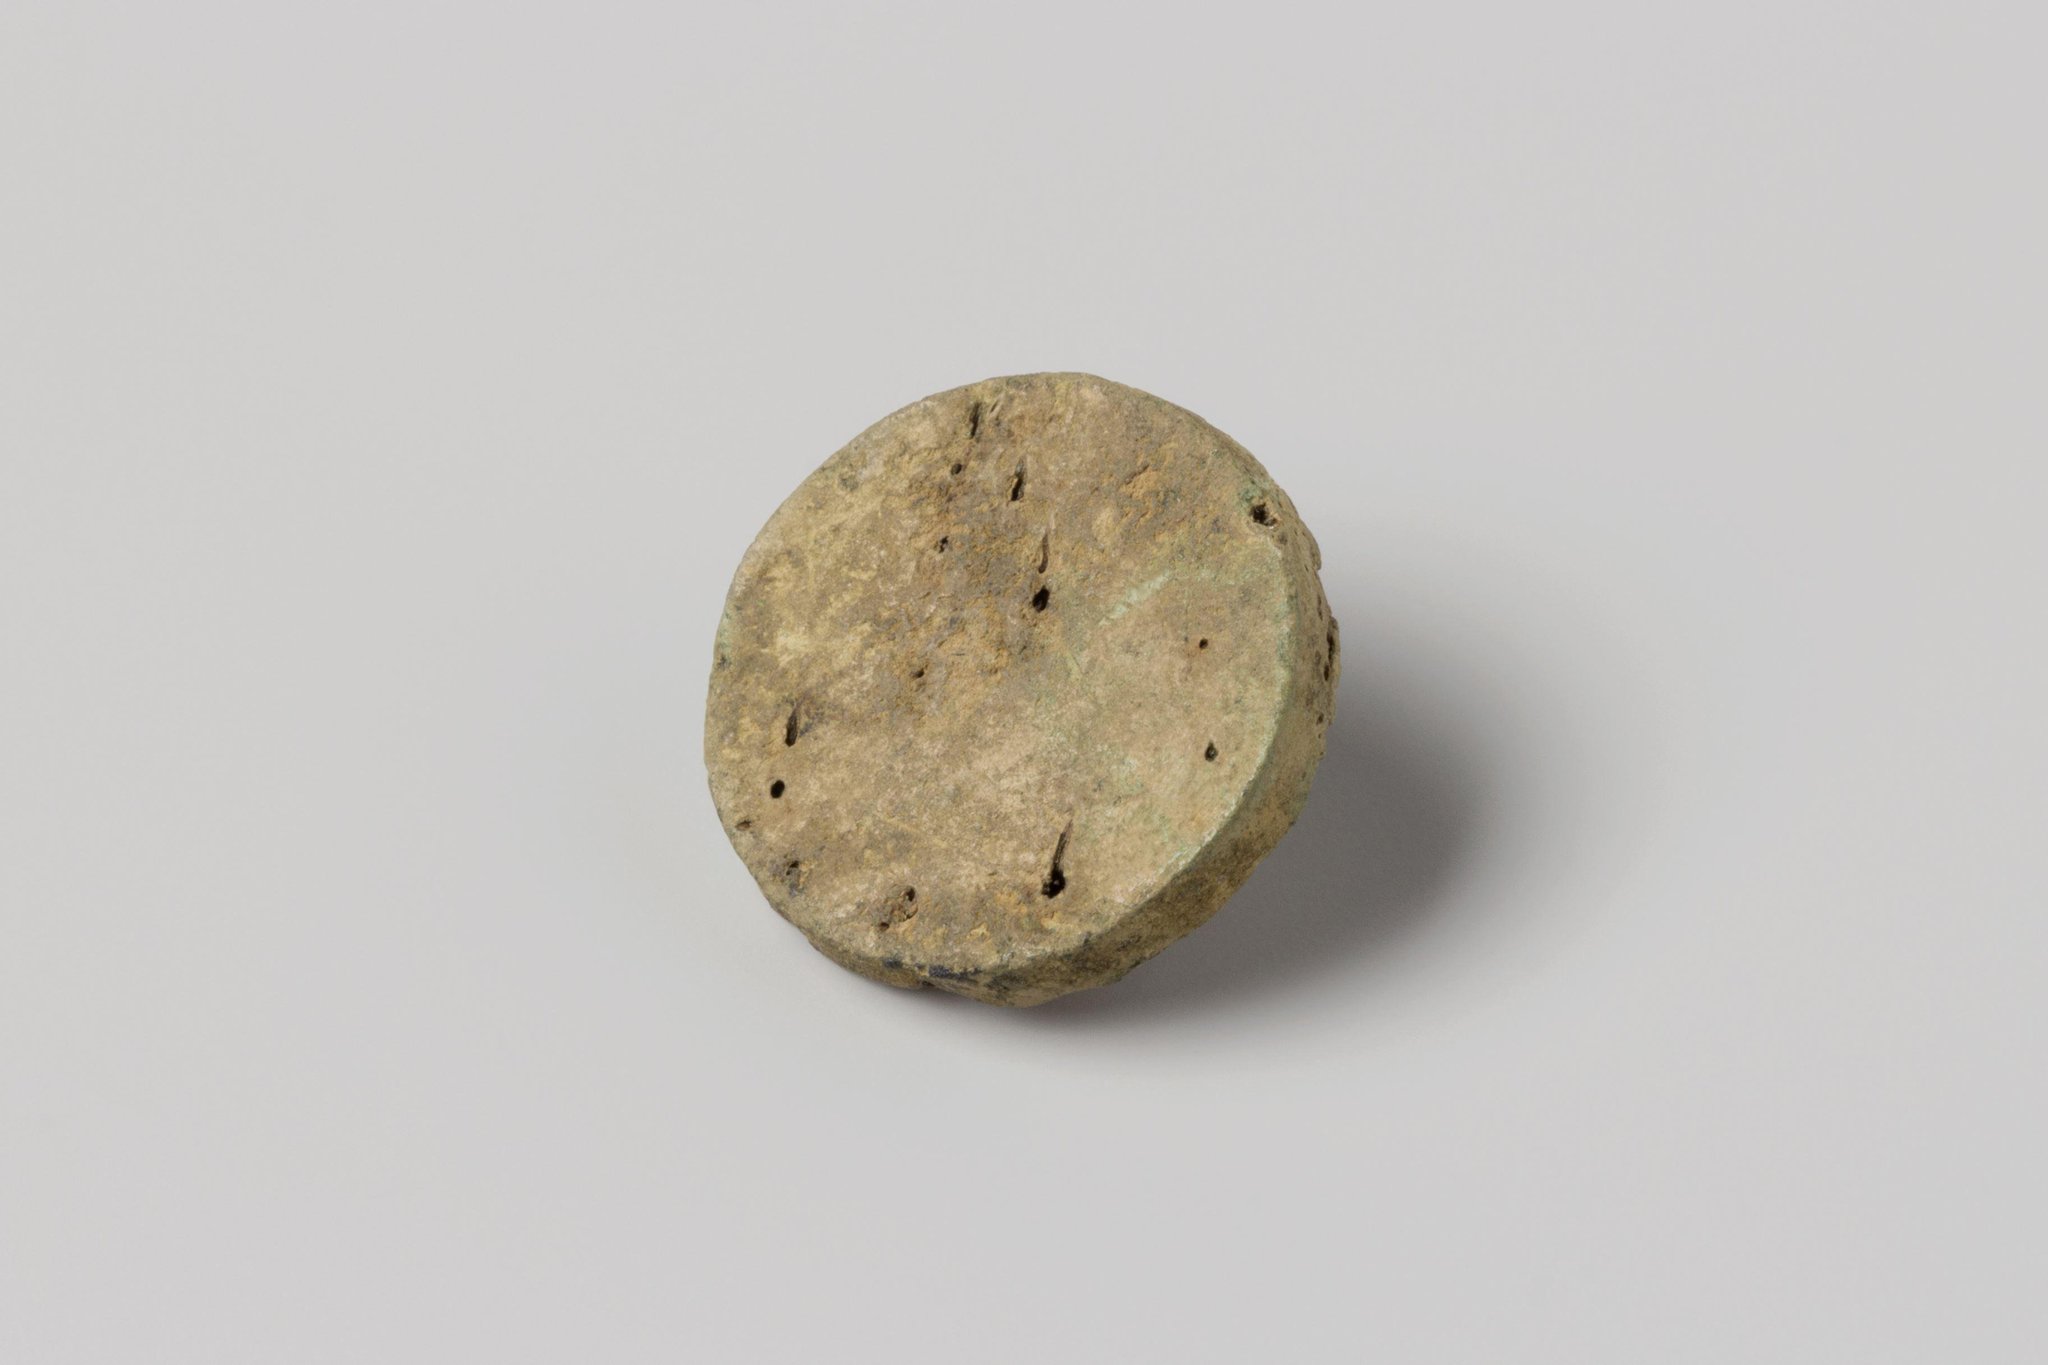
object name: button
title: Knoop uit het wrak van de Oost-Indiëvaarder Hollandia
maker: Anonymous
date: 1700-1743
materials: bone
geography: netherlands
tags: verenigde oostindische compagnie, hollandia (schip), annet